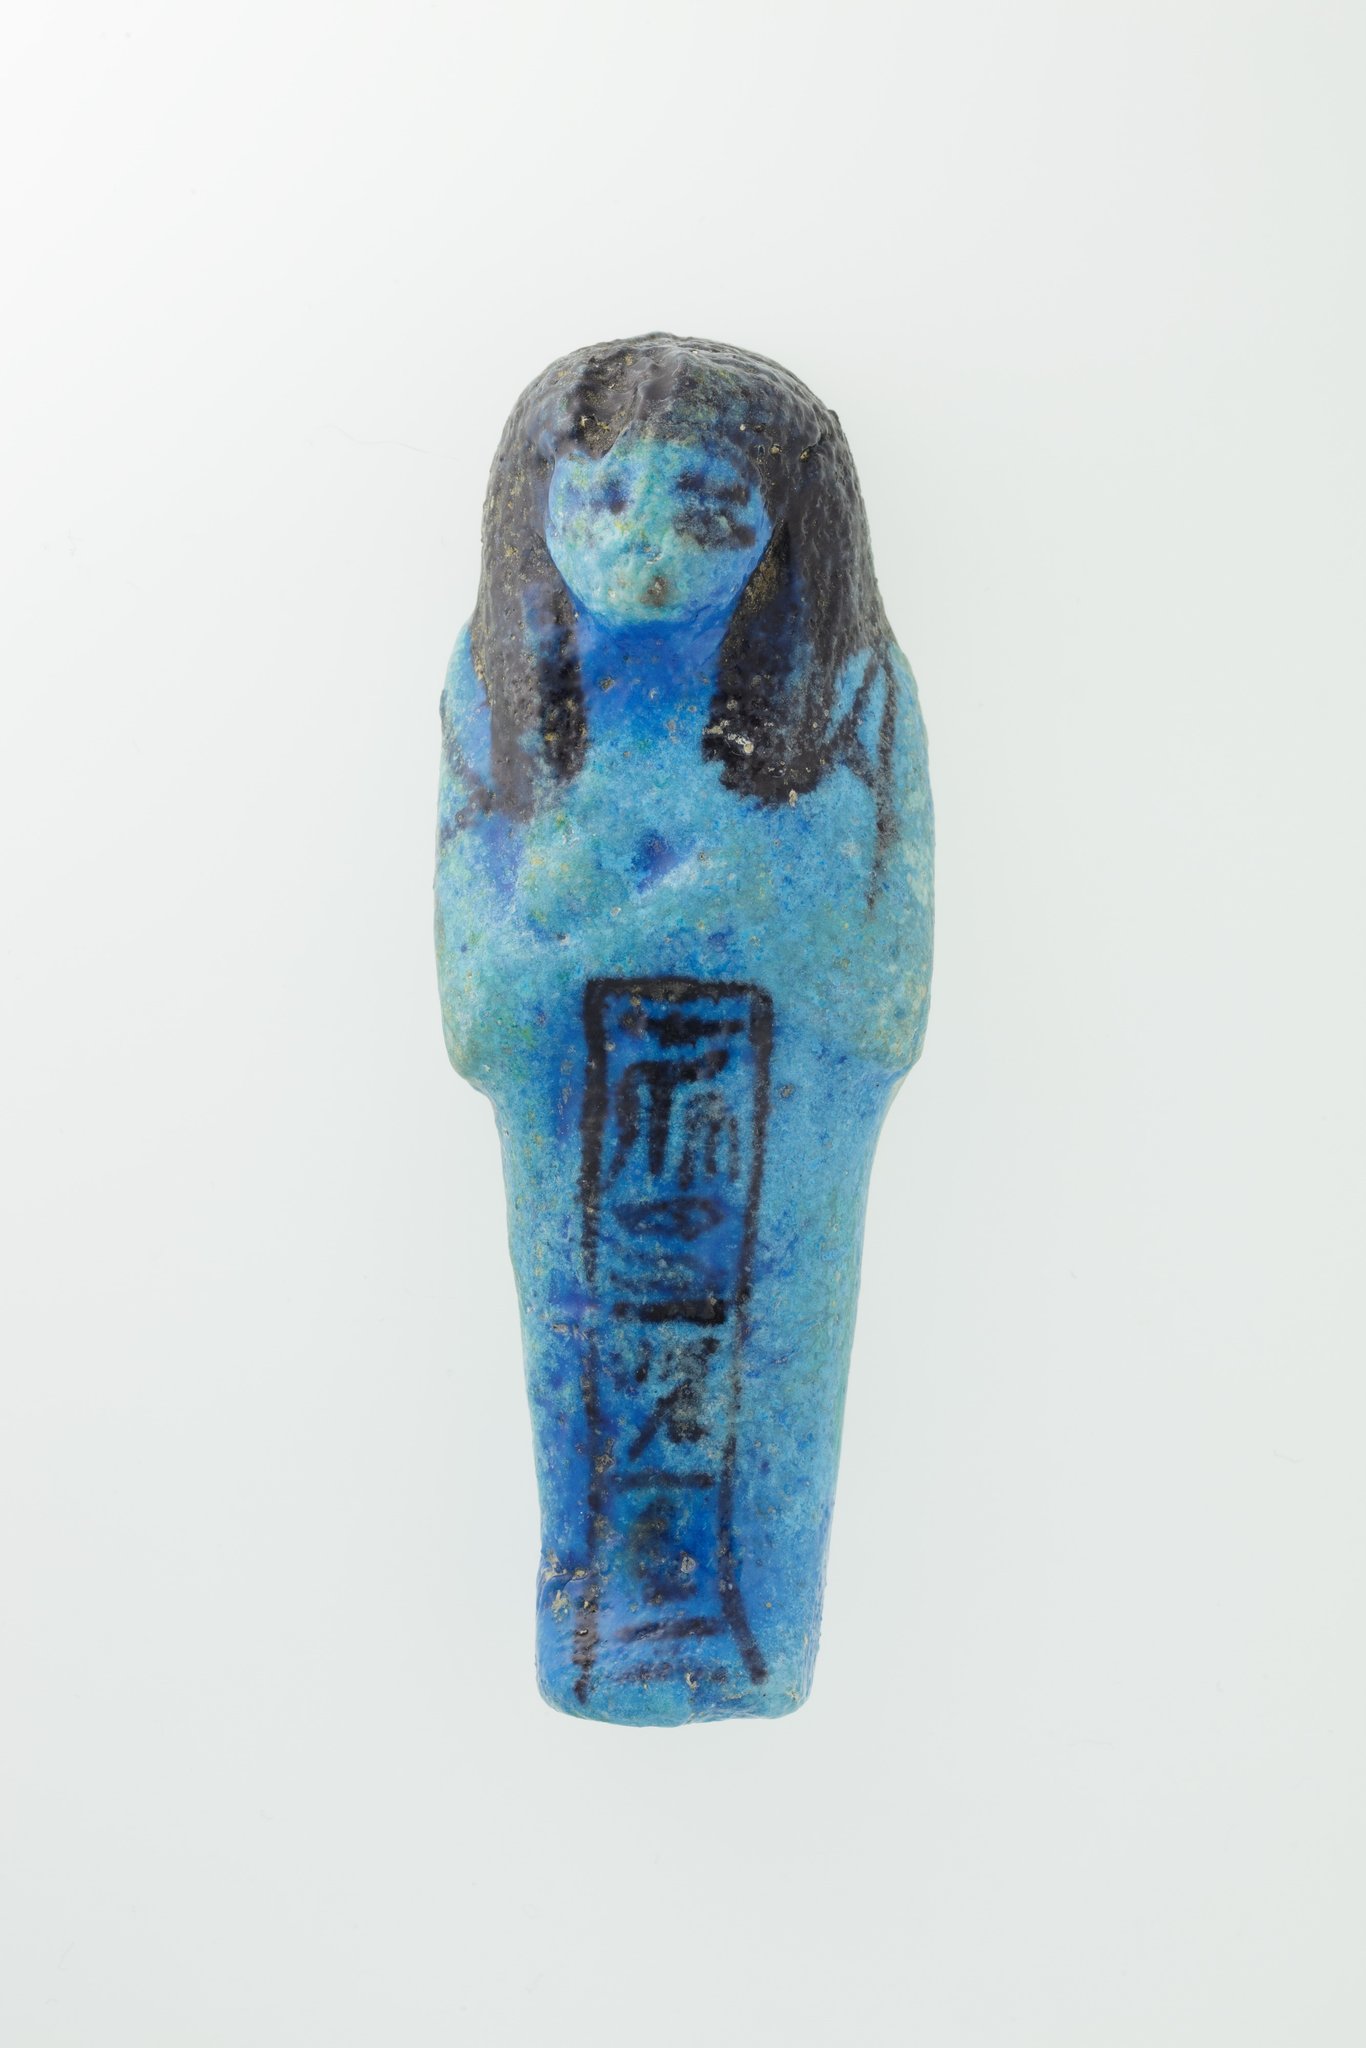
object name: shabti, worker, nauny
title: Worker Shabti of Nauny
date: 1050 BCE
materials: faience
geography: egypt